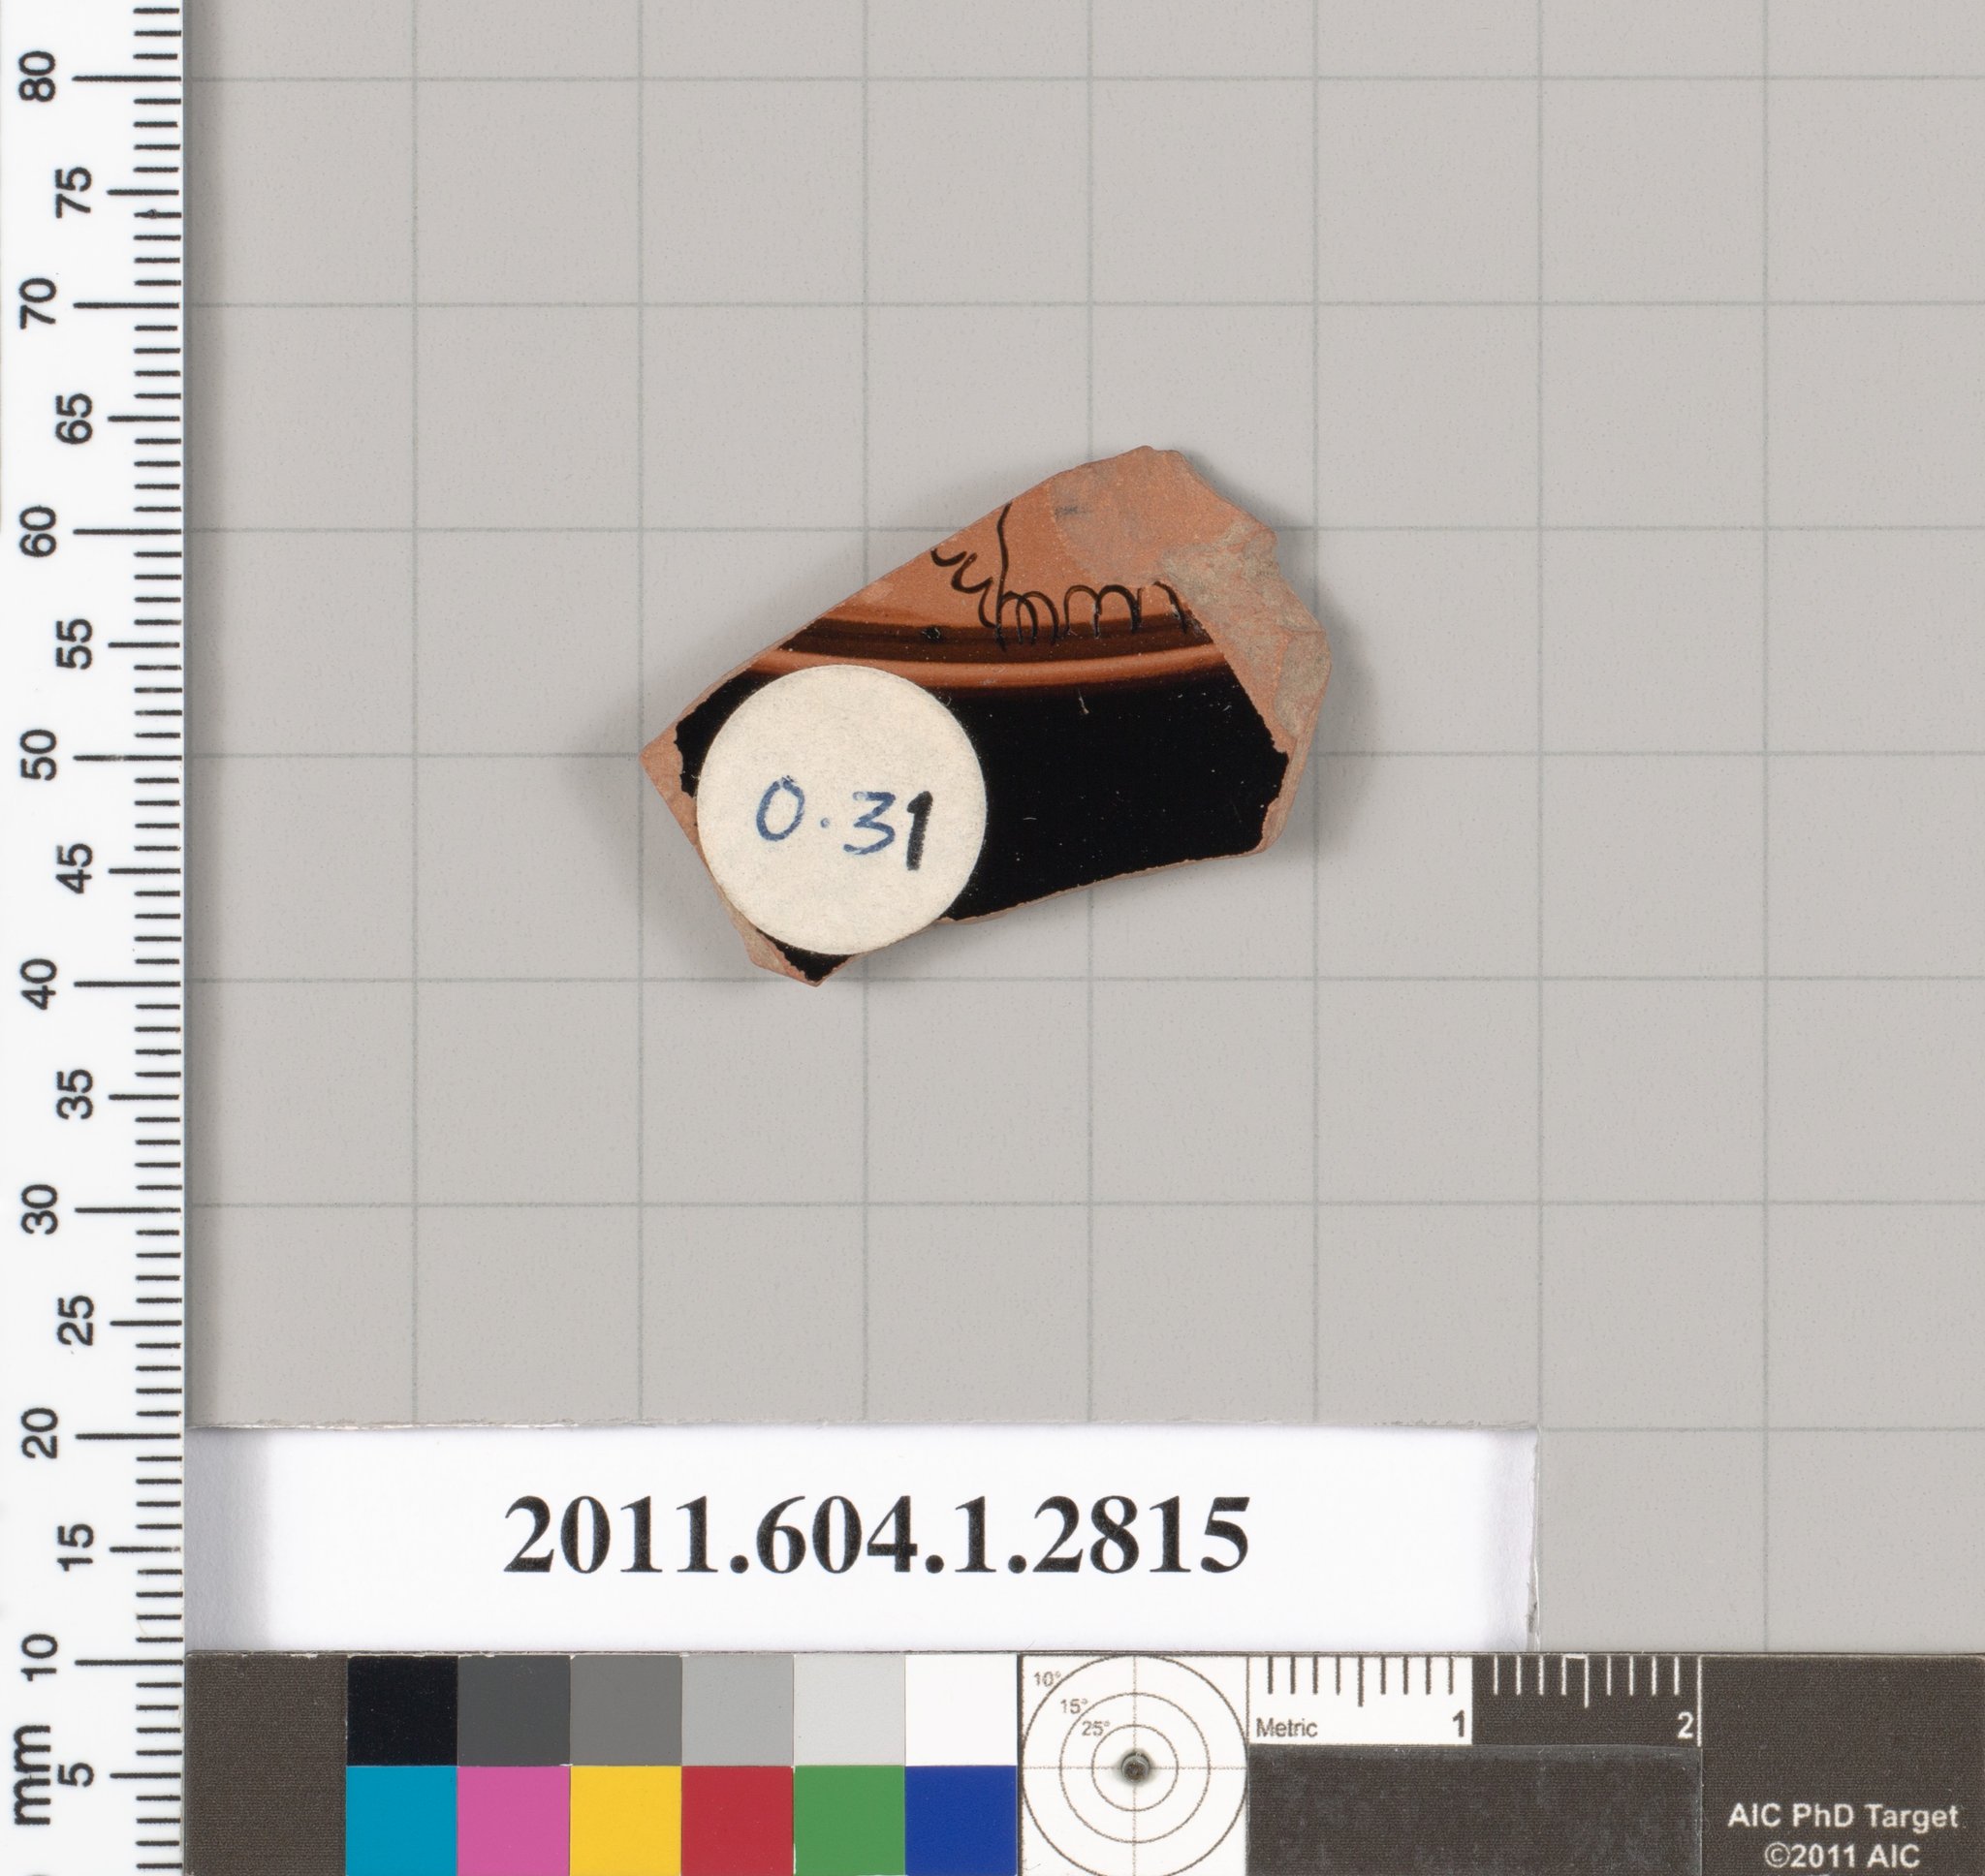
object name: kylix fragment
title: Terracotta fragment of a kylix (drinking cup)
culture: greek, attic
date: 510-490 BCE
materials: terracotta